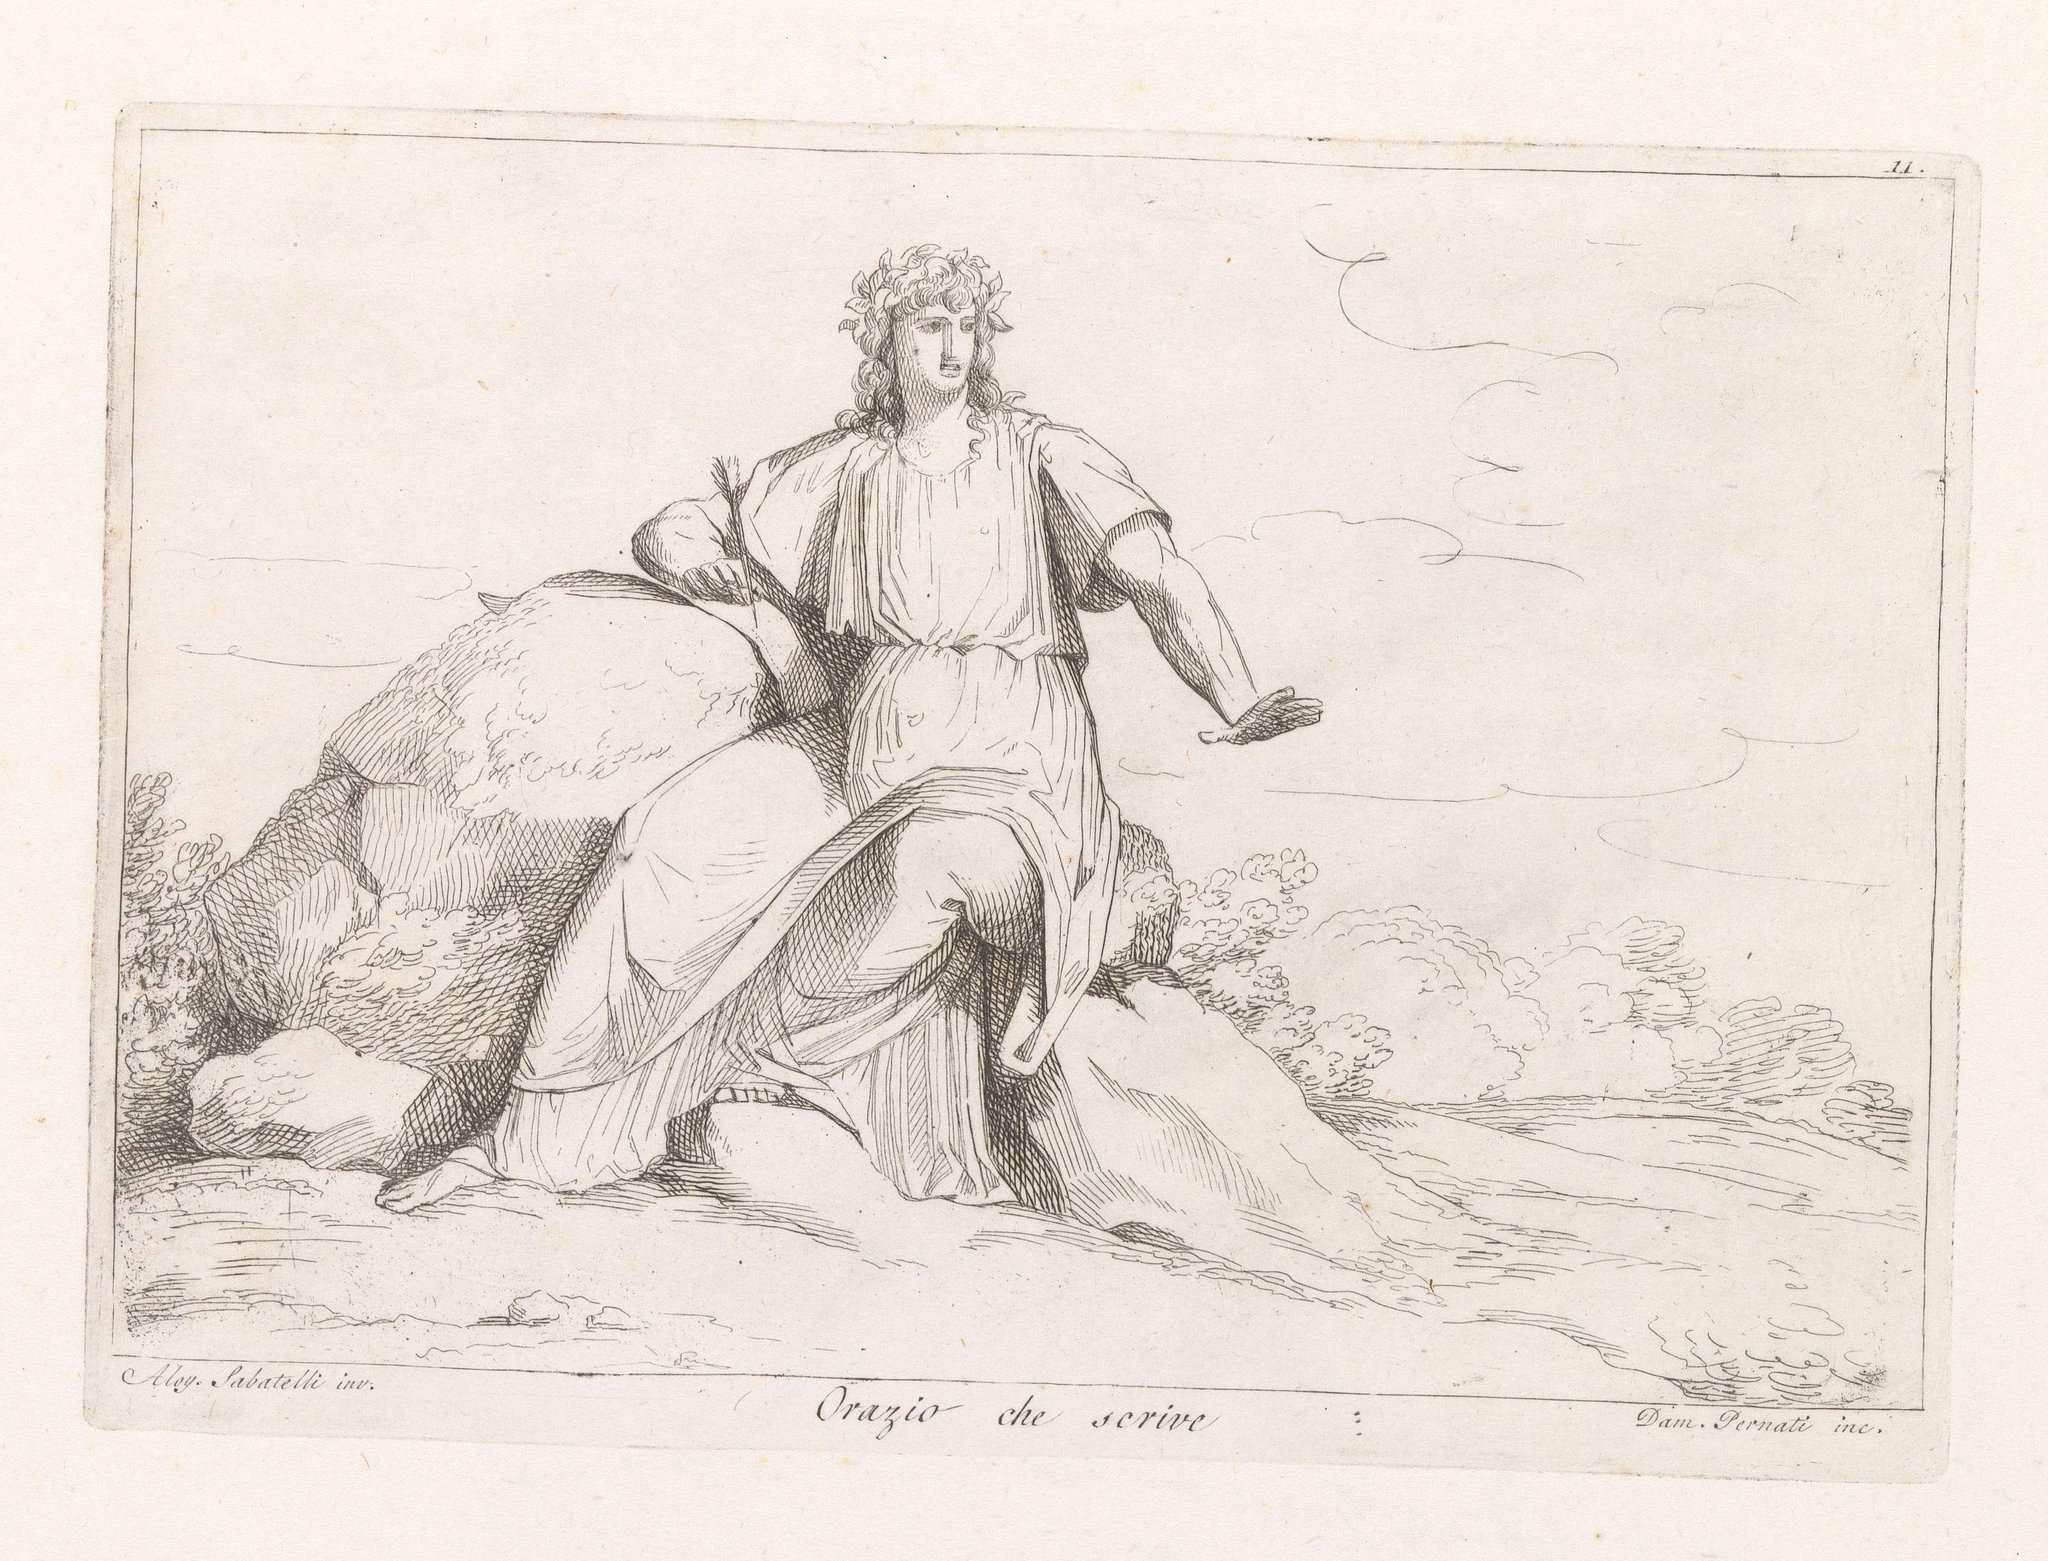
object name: print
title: Horatius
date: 1804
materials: paper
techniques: etching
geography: rome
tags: venosa, rome, horatius, author, poet writing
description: Horatius, schrijvend. Prent nr. 11 op blad 7 in het album 'Raccolta di Soggetti Pittorici', een prentalbum met 42 genummerde etsen op 28 pagina's van Luigi Sabatelli (I) zelf en van leerlingen naar diens ontwerp.